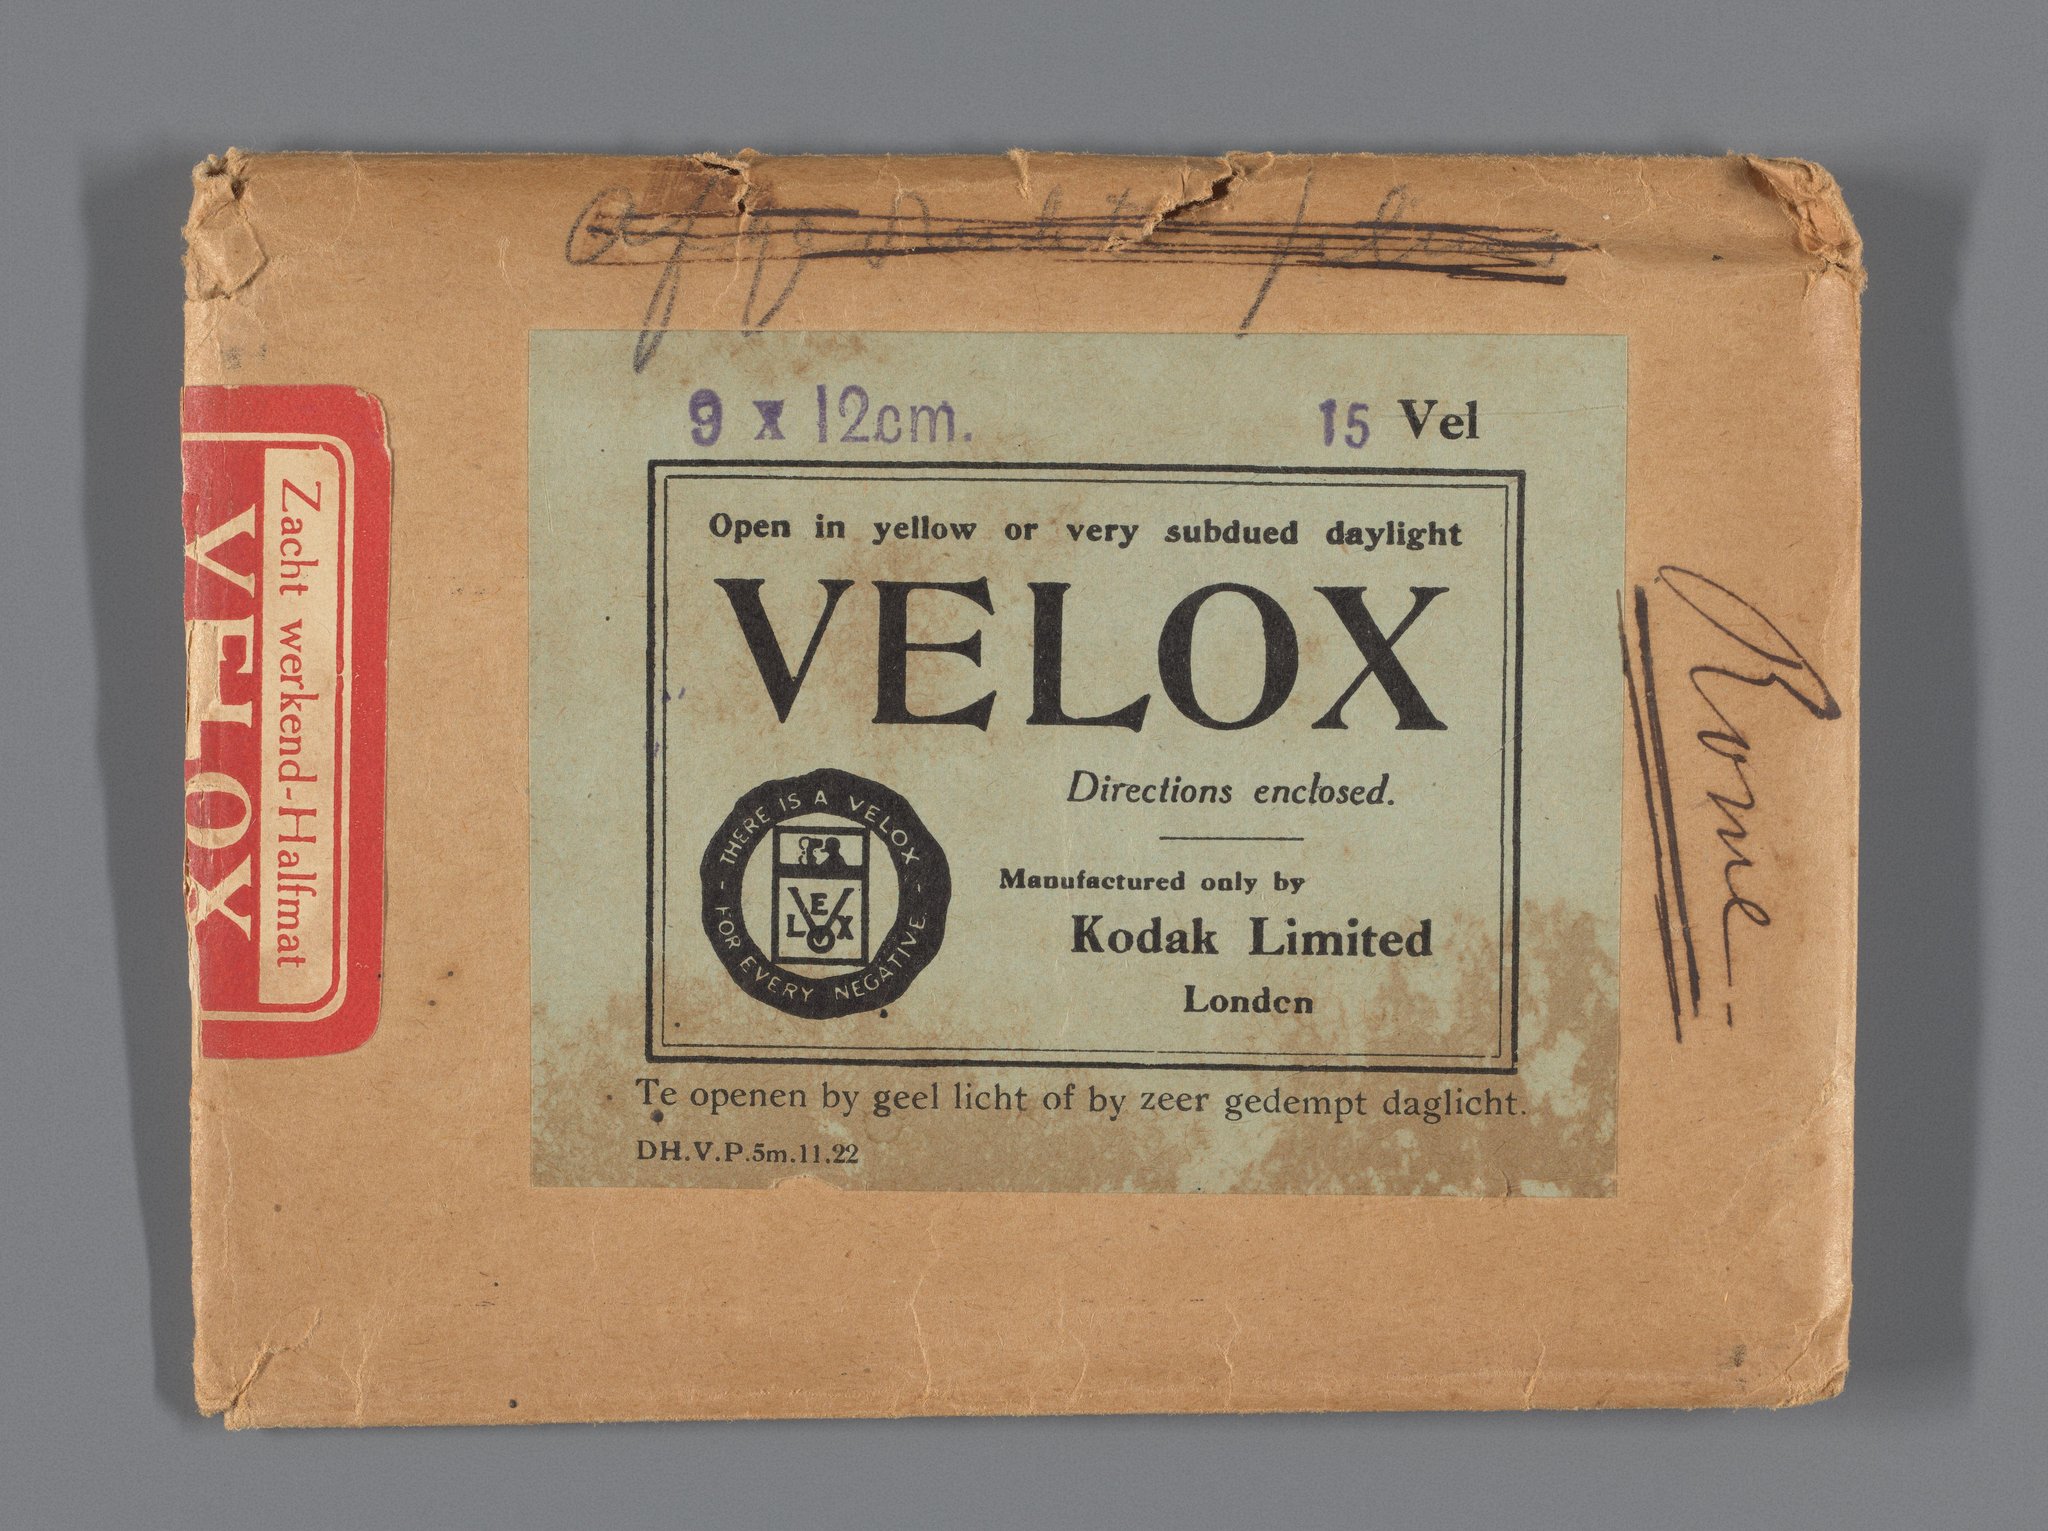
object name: envelope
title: Envelop voor fotopapier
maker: Anonymous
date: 1907-1935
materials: paper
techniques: printing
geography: europe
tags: rome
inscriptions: inscription: ‘Rome’